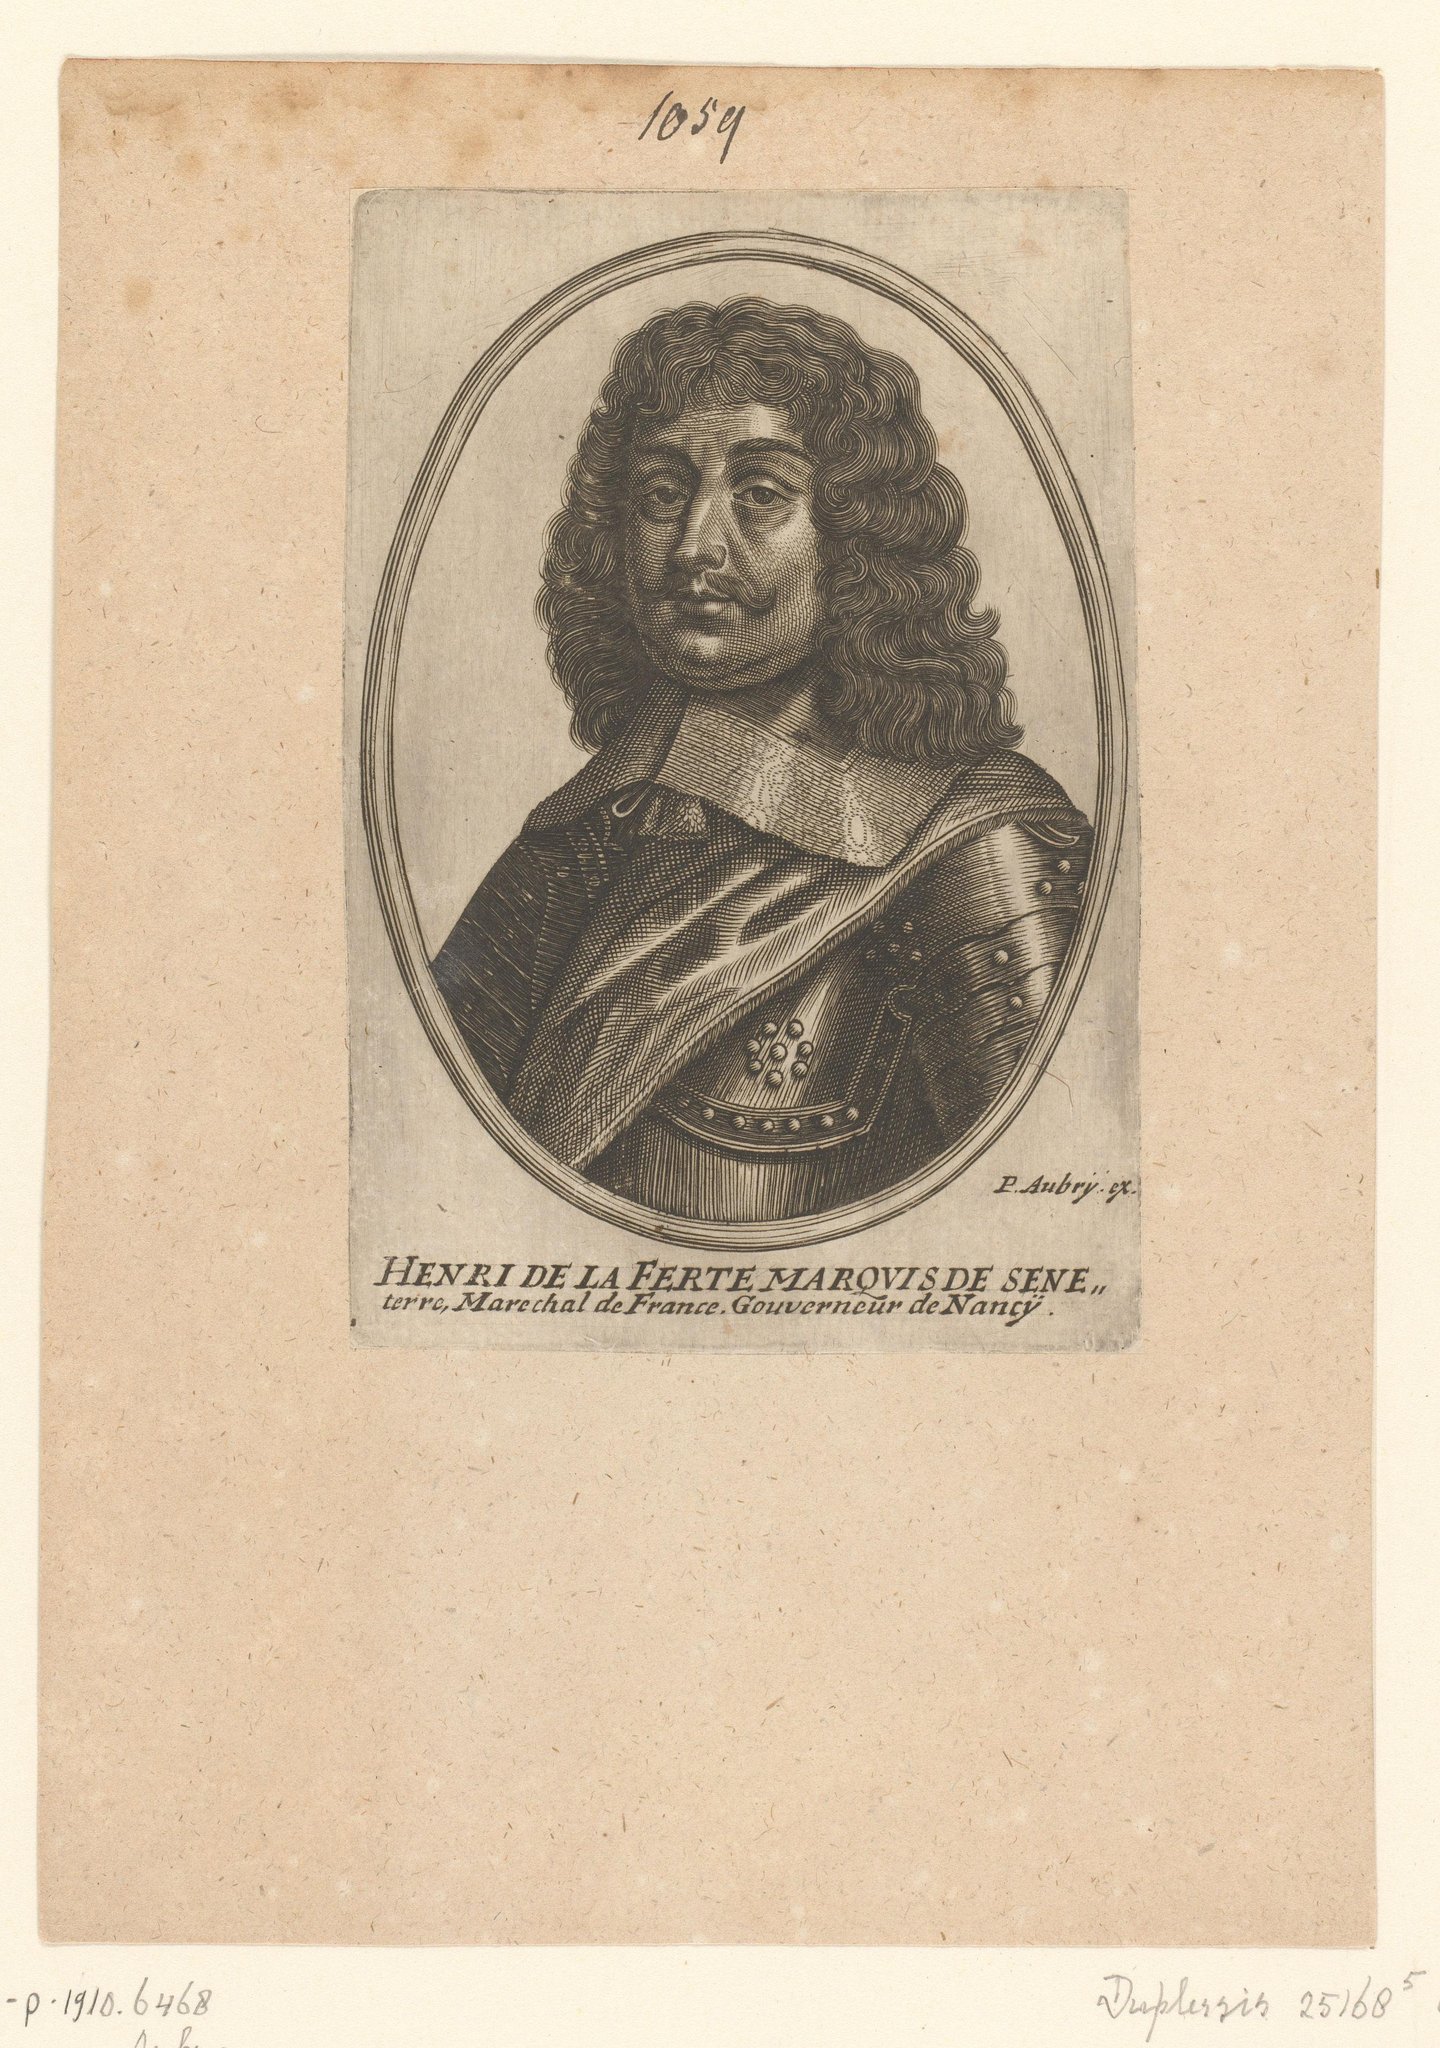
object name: print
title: Portret van Henri de la Ferté-Senneterre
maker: Anonymous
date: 1639-1686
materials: paper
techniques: engraving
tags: politician, commander-in-chief, general, marshal, historical persons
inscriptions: collector's mark: Lugt 2228, number: ‘1059’